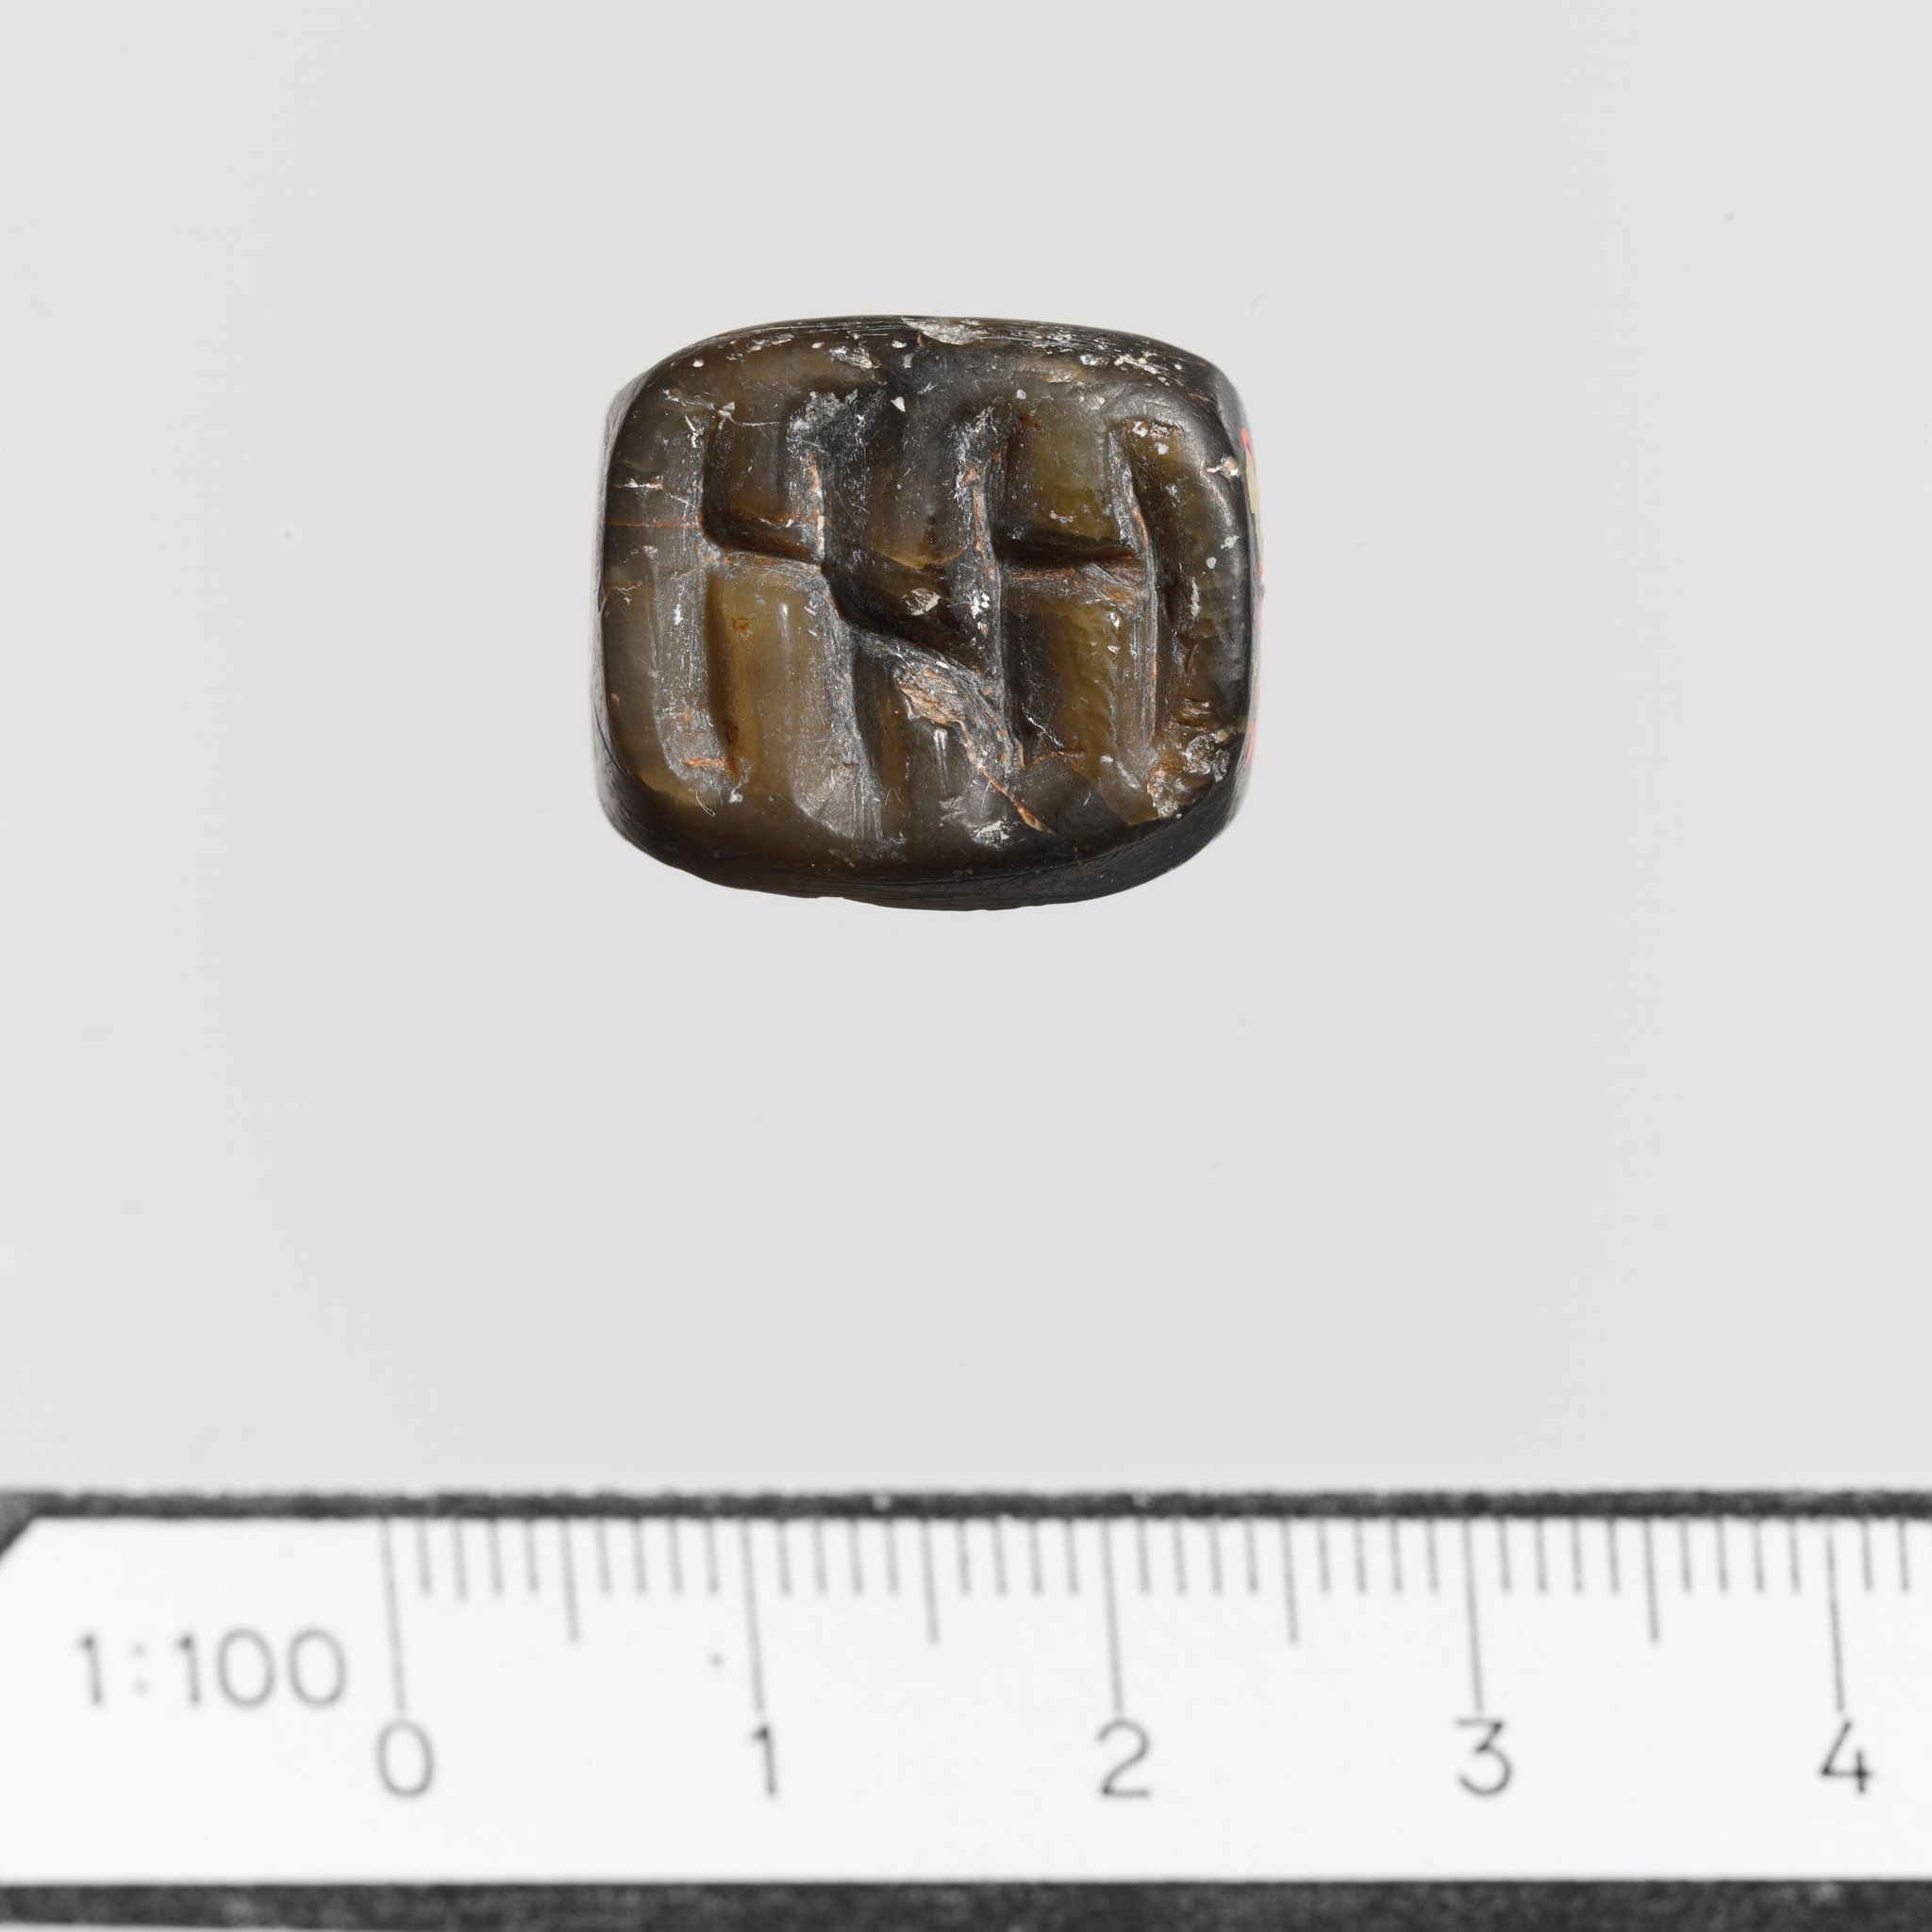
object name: seal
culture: minoan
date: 2600-2000 BCE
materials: stone